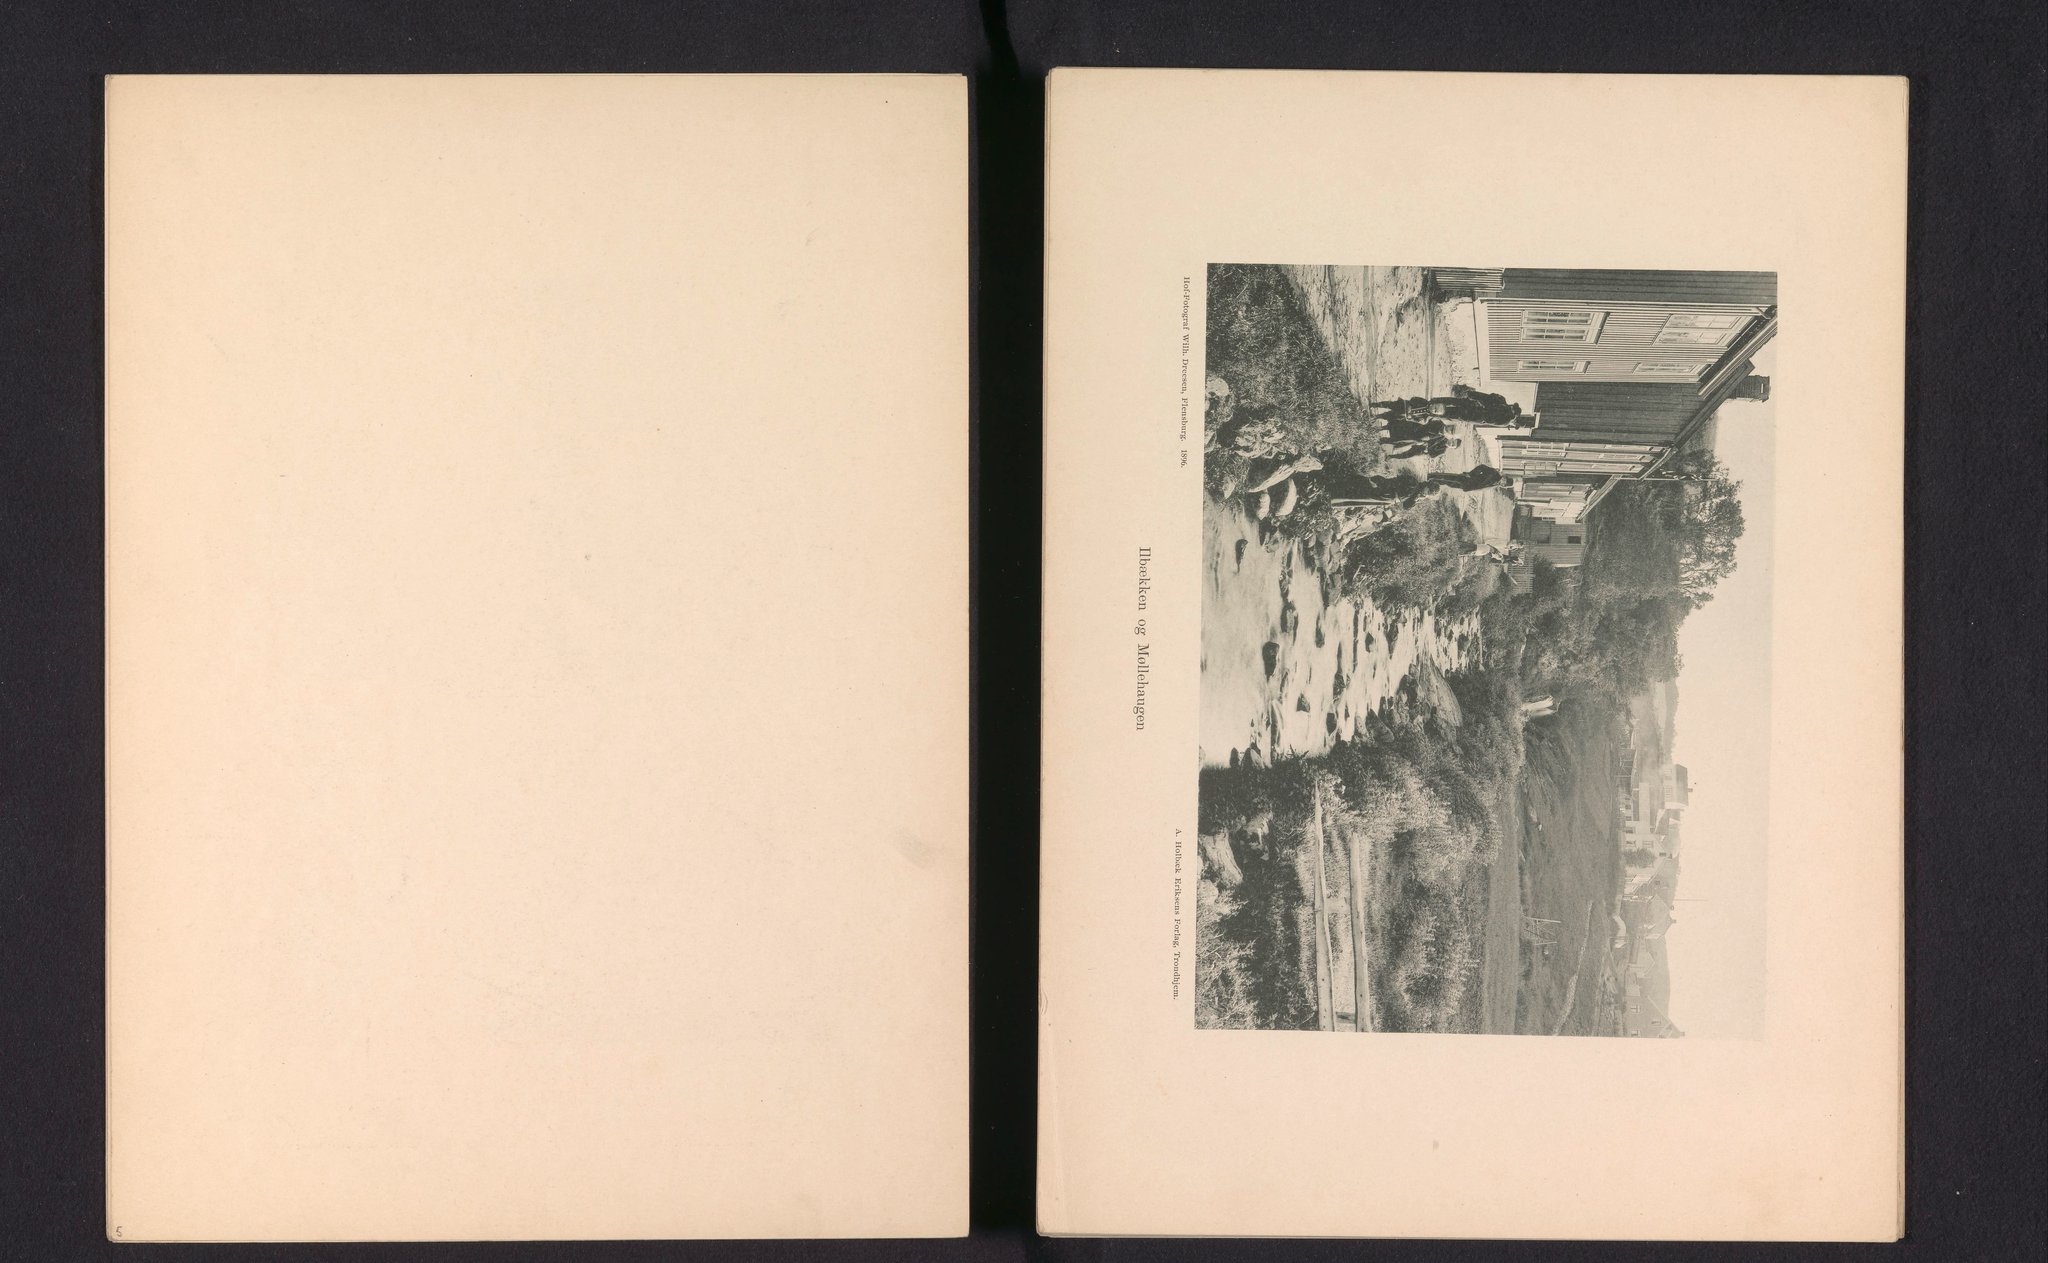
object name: page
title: Ilbaekken og Møllehaugen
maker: wilhelm dreesen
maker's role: fotograaf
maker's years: 1840-1926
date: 1896-1897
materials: paper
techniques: photograph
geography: trondheim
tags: low hill country, river, housing